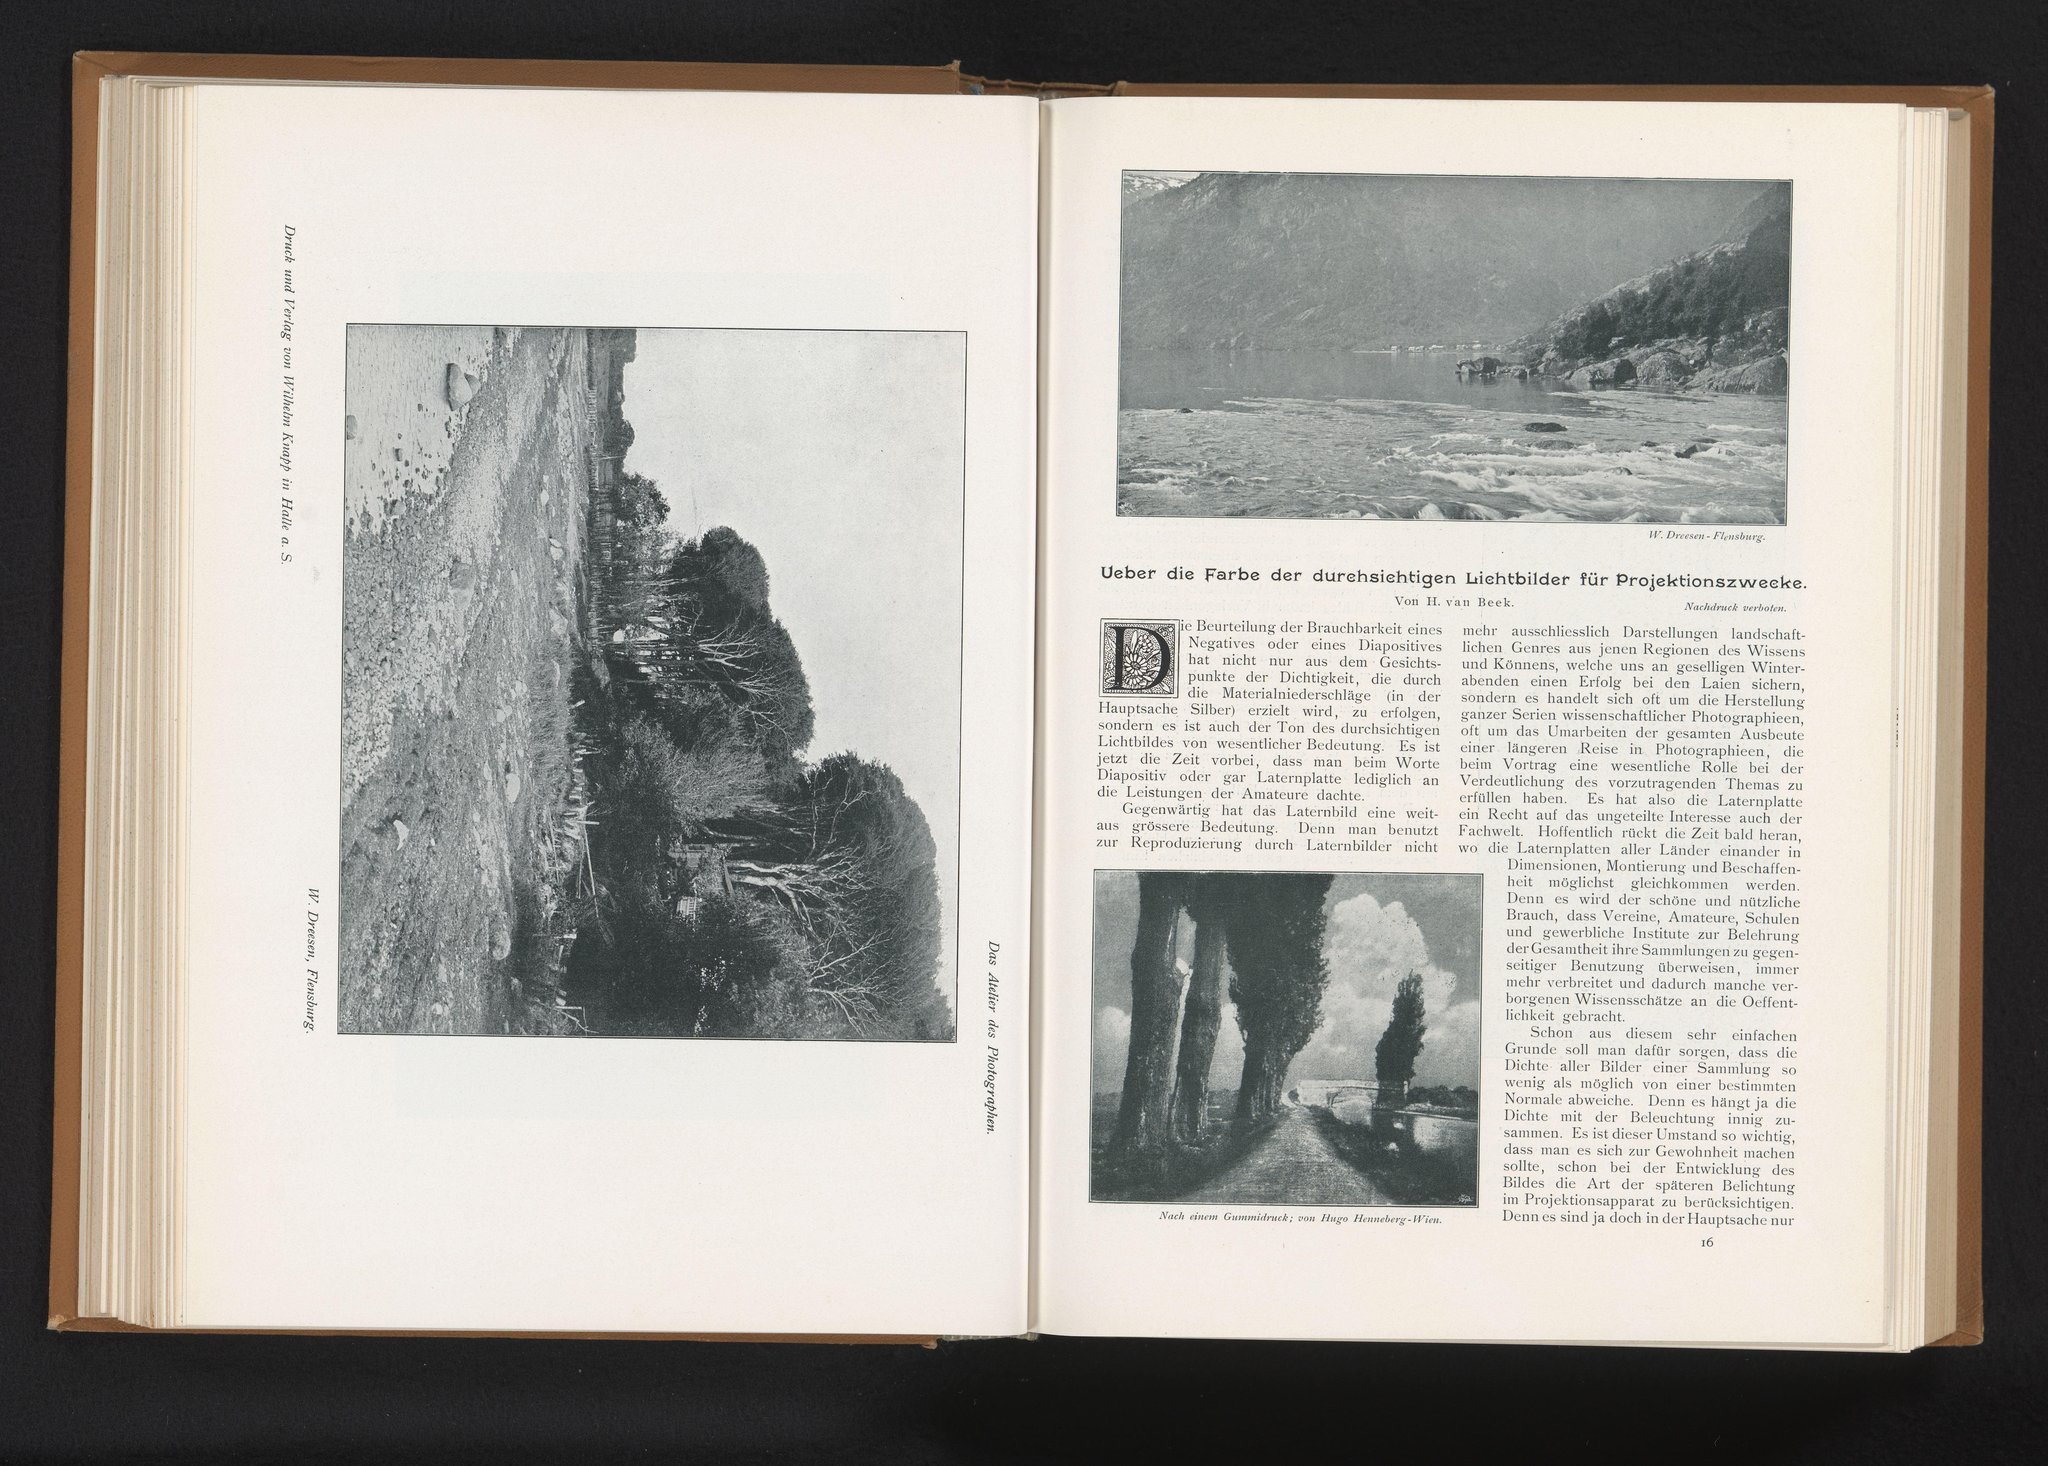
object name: photomechanical print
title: Landschap met bomenrij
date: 1895-1900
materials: paper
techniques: autotype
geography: berlin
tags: trees, landscapes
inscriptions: inscription: ‘Das Atelier des Photographen.’